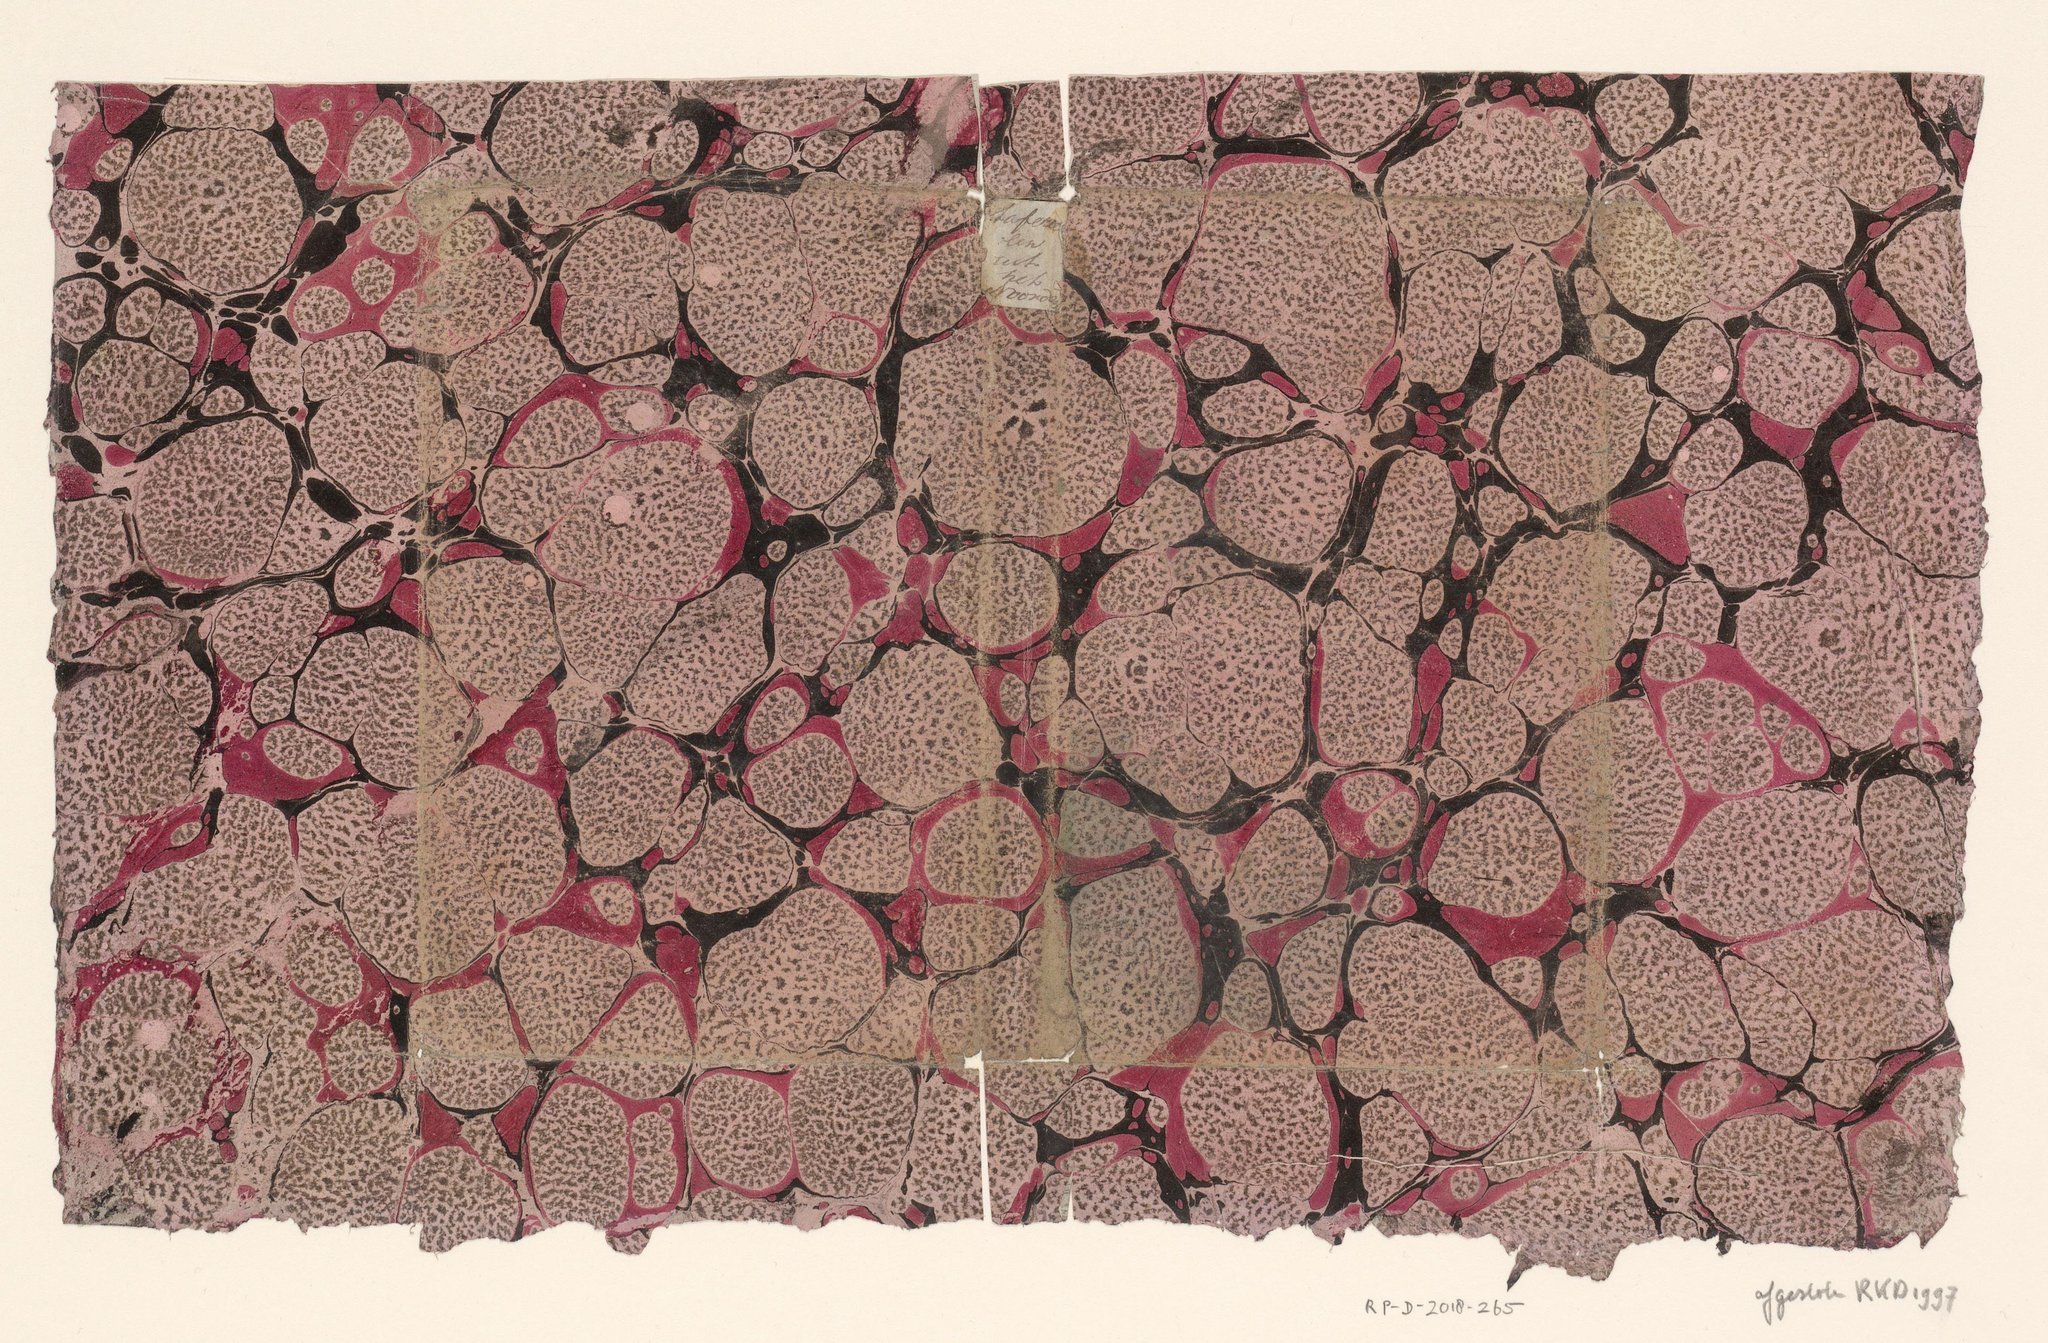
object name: marbled paper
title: Gruismarmer in rood, zwart en roze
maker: Anonymous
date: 1700-1900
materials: paint, paper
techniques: marbled paper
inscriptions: collector's mark: Lugt 2228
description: Gruismarmer in rood, zwart en roze. Gebruikt als omslag, met insnijdingen bij de rug. Op de rug een etiket met opschrift: '... het Noorden.'